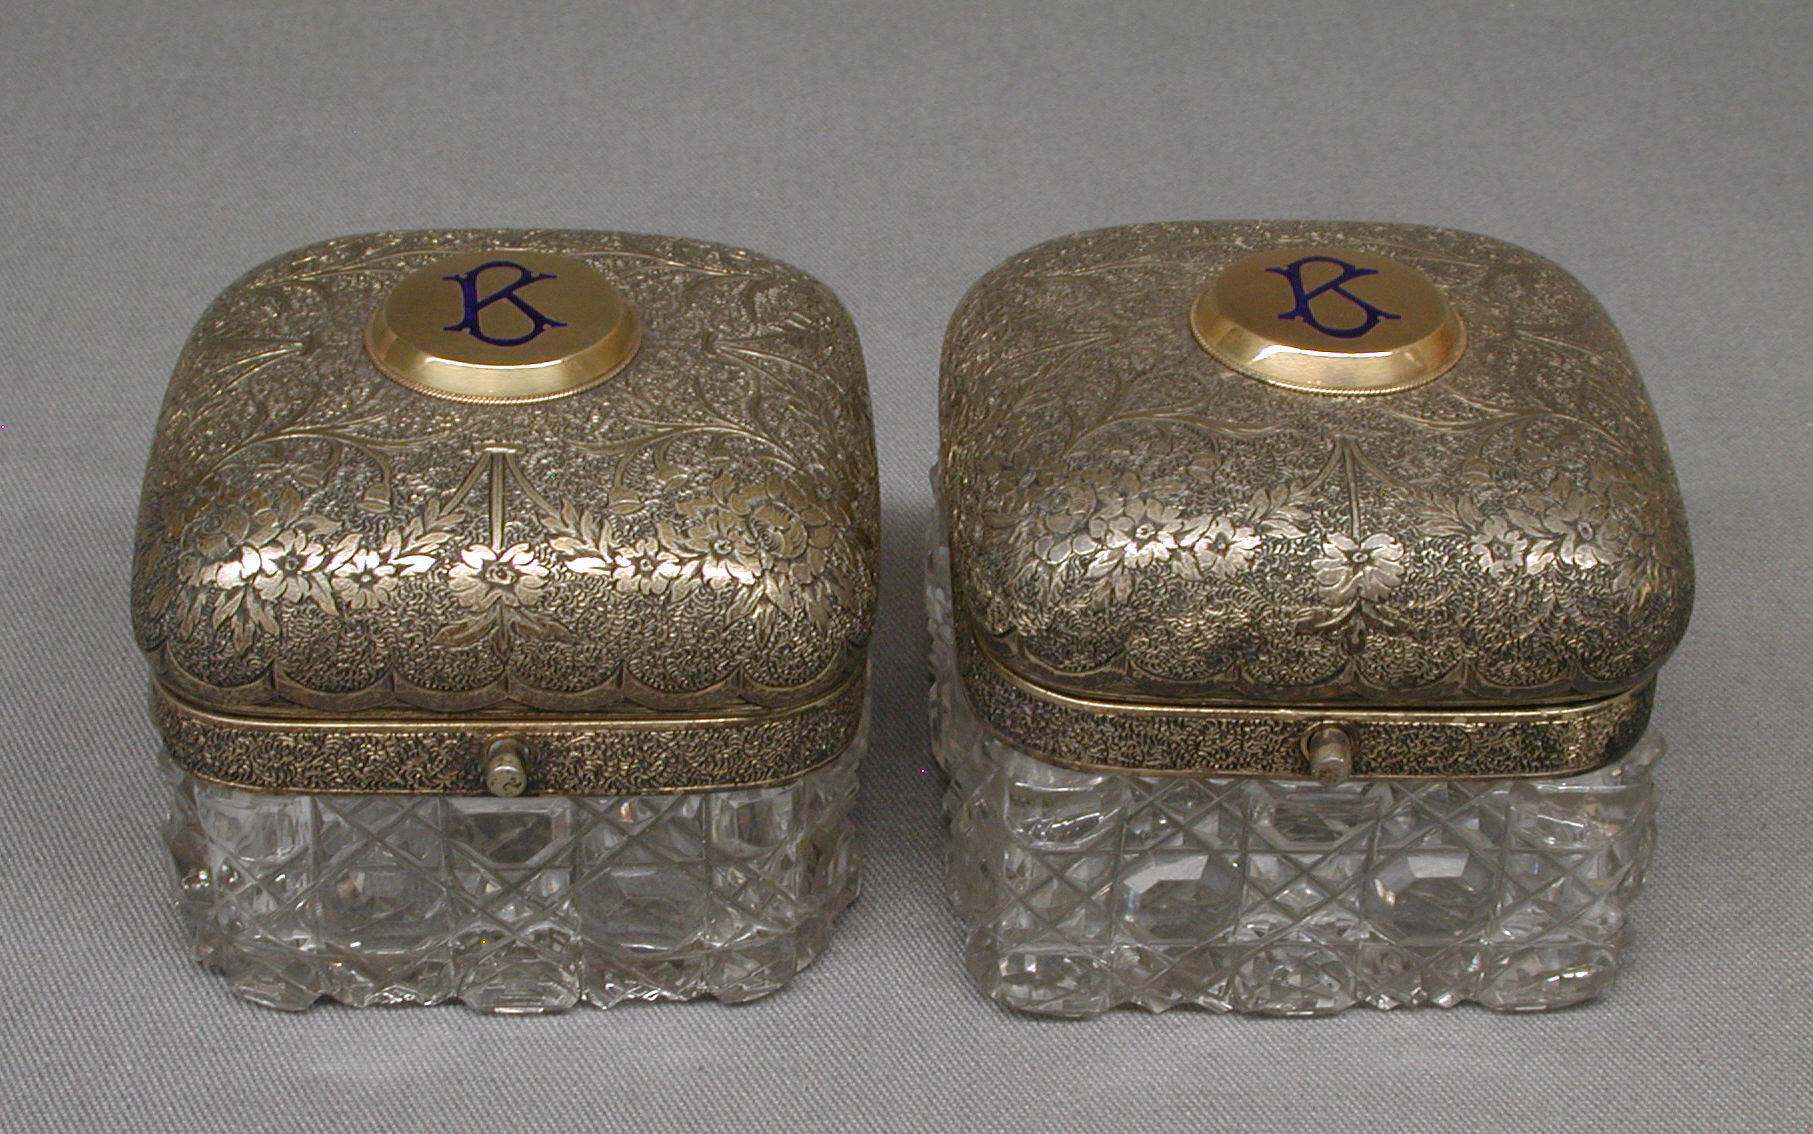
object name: cosmetic jar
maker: barnard brothers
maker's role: maker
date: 1874-1875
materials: glass, silver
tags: flowers,insignia